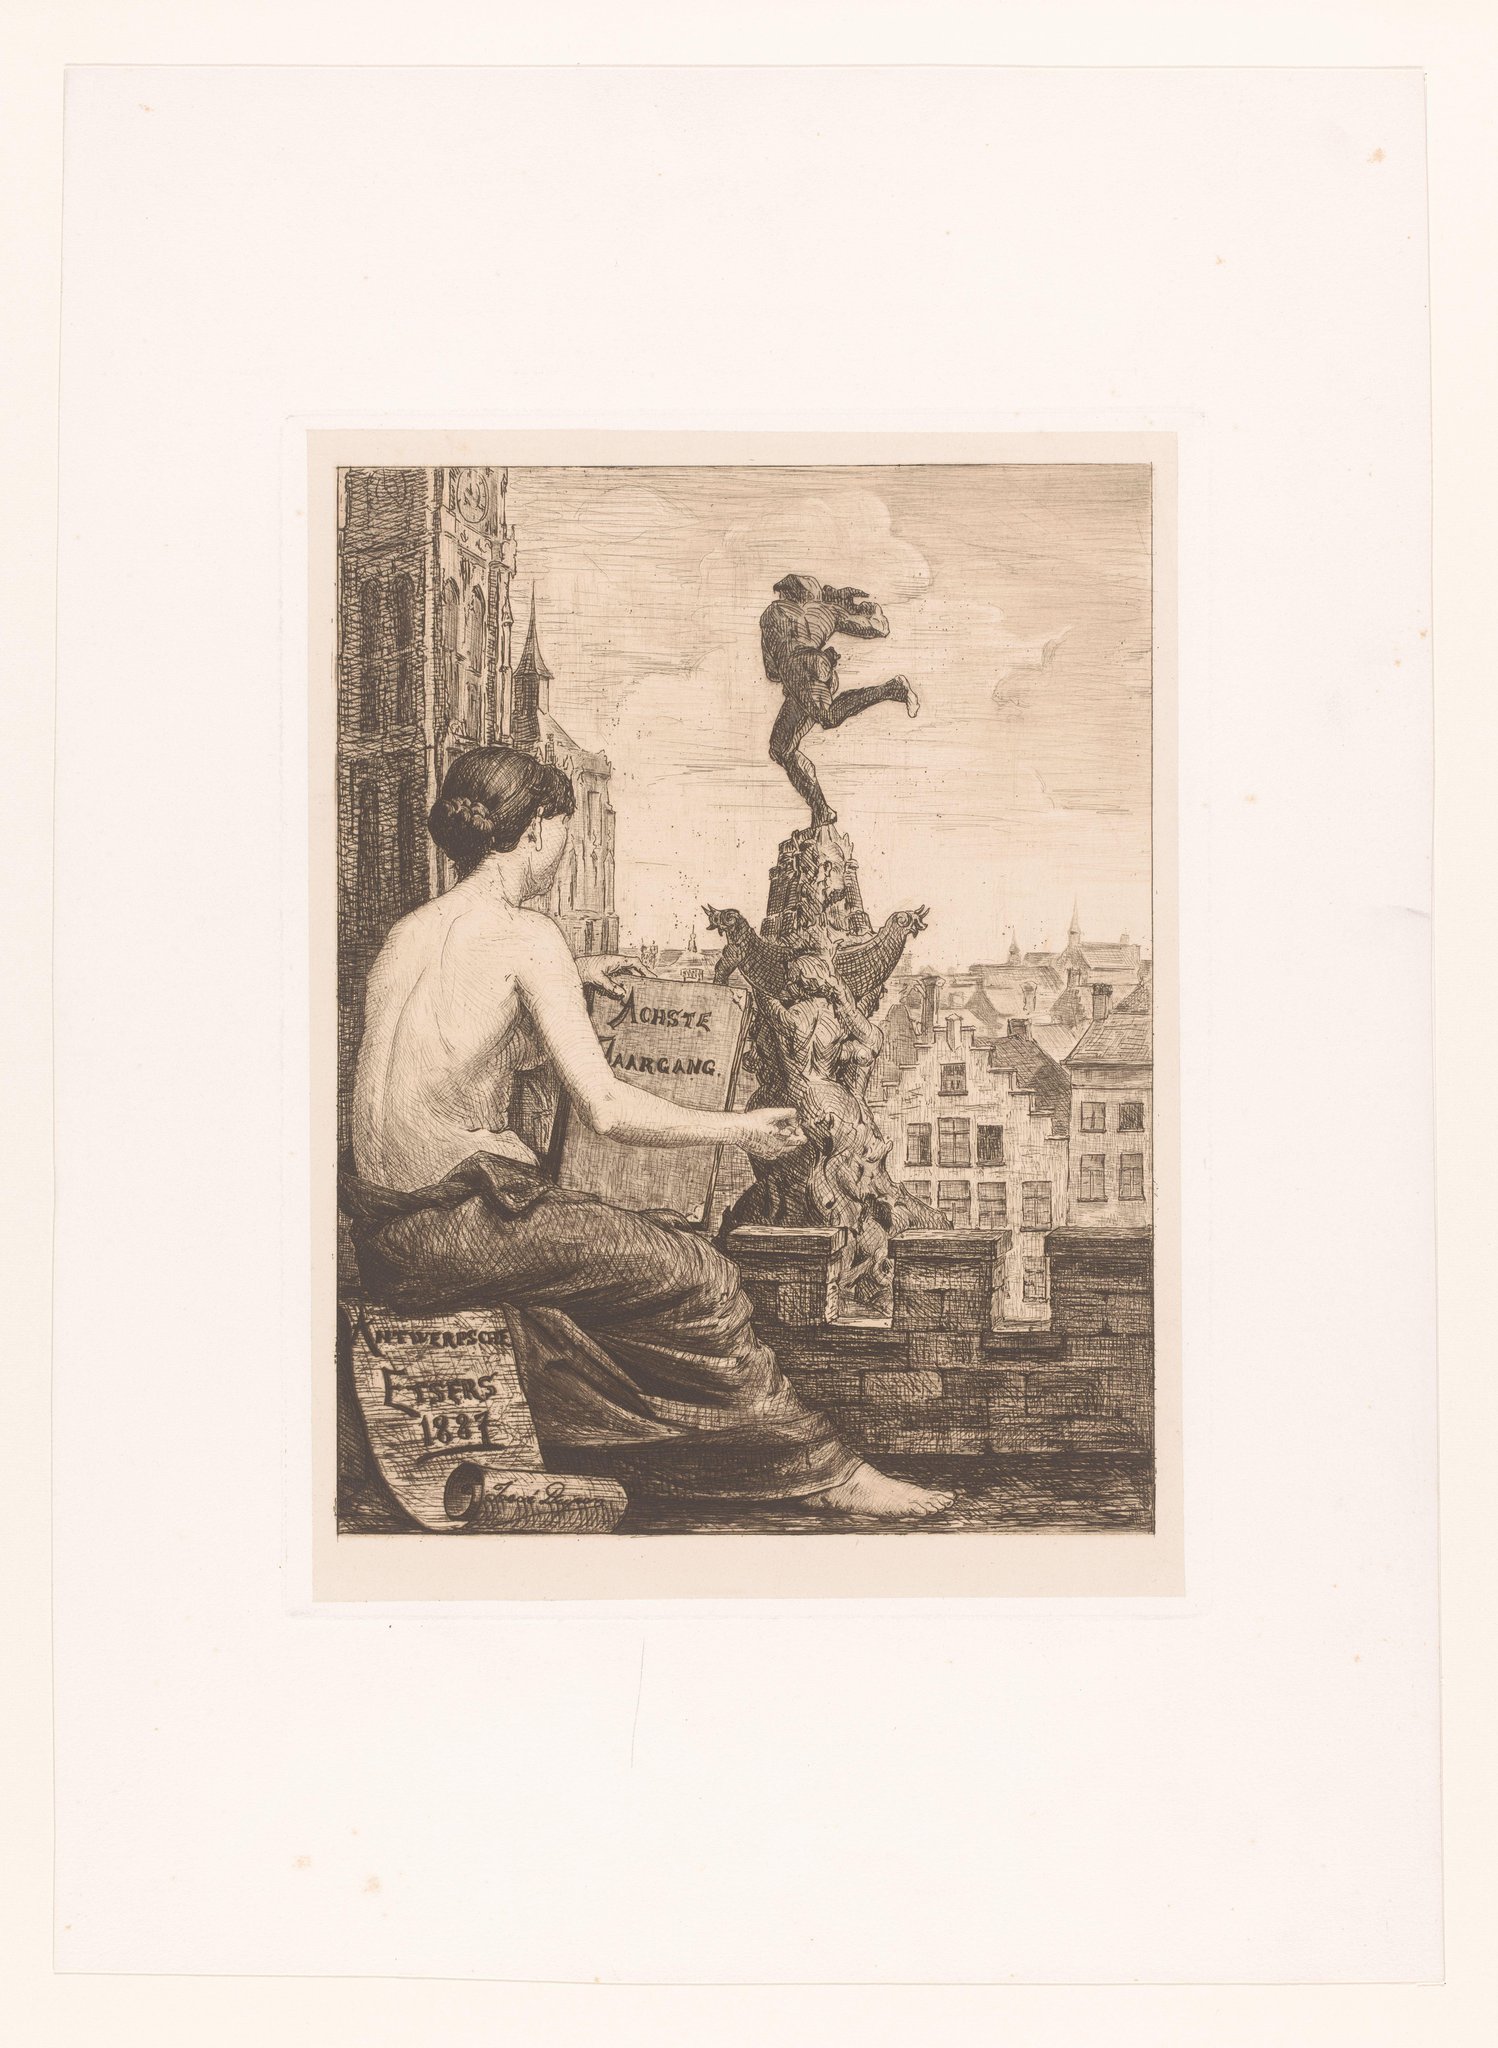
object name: print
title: Achste Jaargang / Antwerpsche Etsers 1887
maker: josué dupon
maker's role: print maker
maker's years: 1864-1935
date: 1887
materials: paper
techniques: etching, roulette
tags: sitting figure - aa - female human figure (+ back view), piece of sculpture, reproduction of a piece of sculpture, market, antwerp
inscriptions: collector's mark: Lugt 2228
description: Een latere staat van deze prent is waarschijnlijk bedoeld als titelprent voor: Album der Antwerpsche Etsers. S.l.: Vereeniging der Antwerpsche Etsers, 1887.